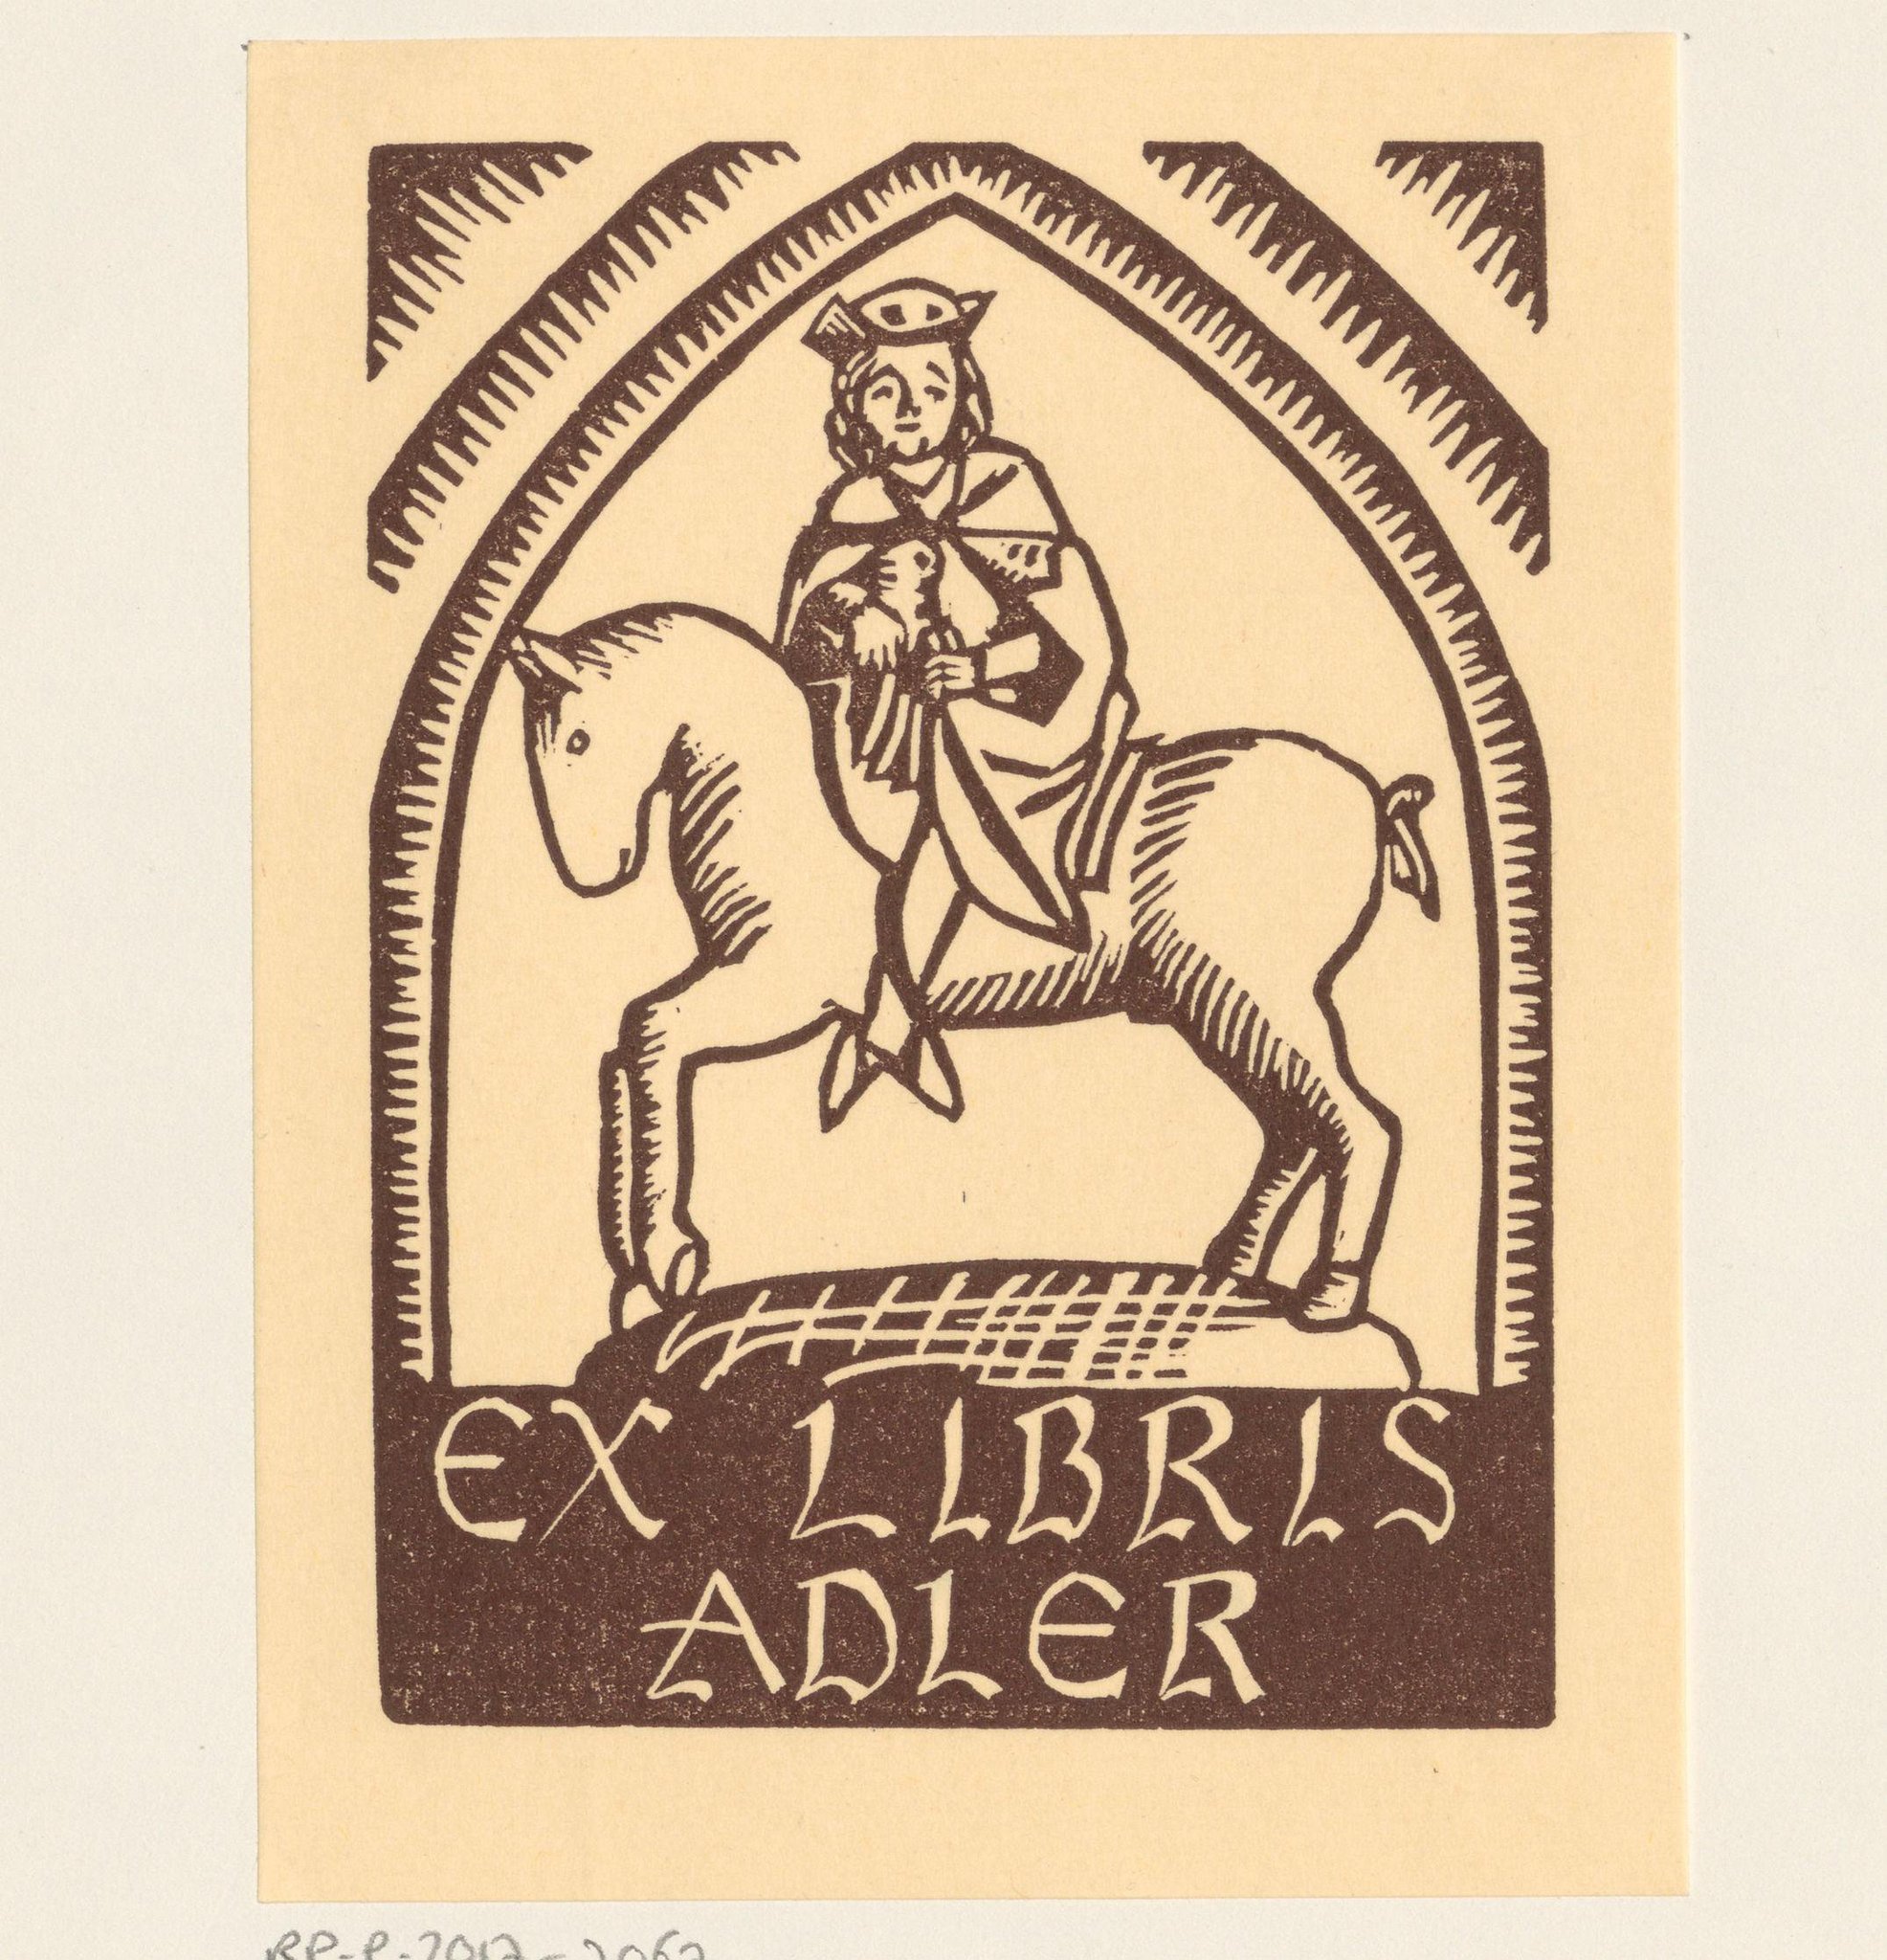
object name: bookplate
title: Ex libris van Adler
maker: leta adler-mckinley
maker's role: print maker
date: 1943-1999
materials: paper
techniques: linocut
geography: austria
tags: vienna, print maker, leta adler-mckinley, martin(us), bishop of tours; possible attributes: beggar, goose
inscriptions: workshop stamp: ‘Leta Adler Lino’